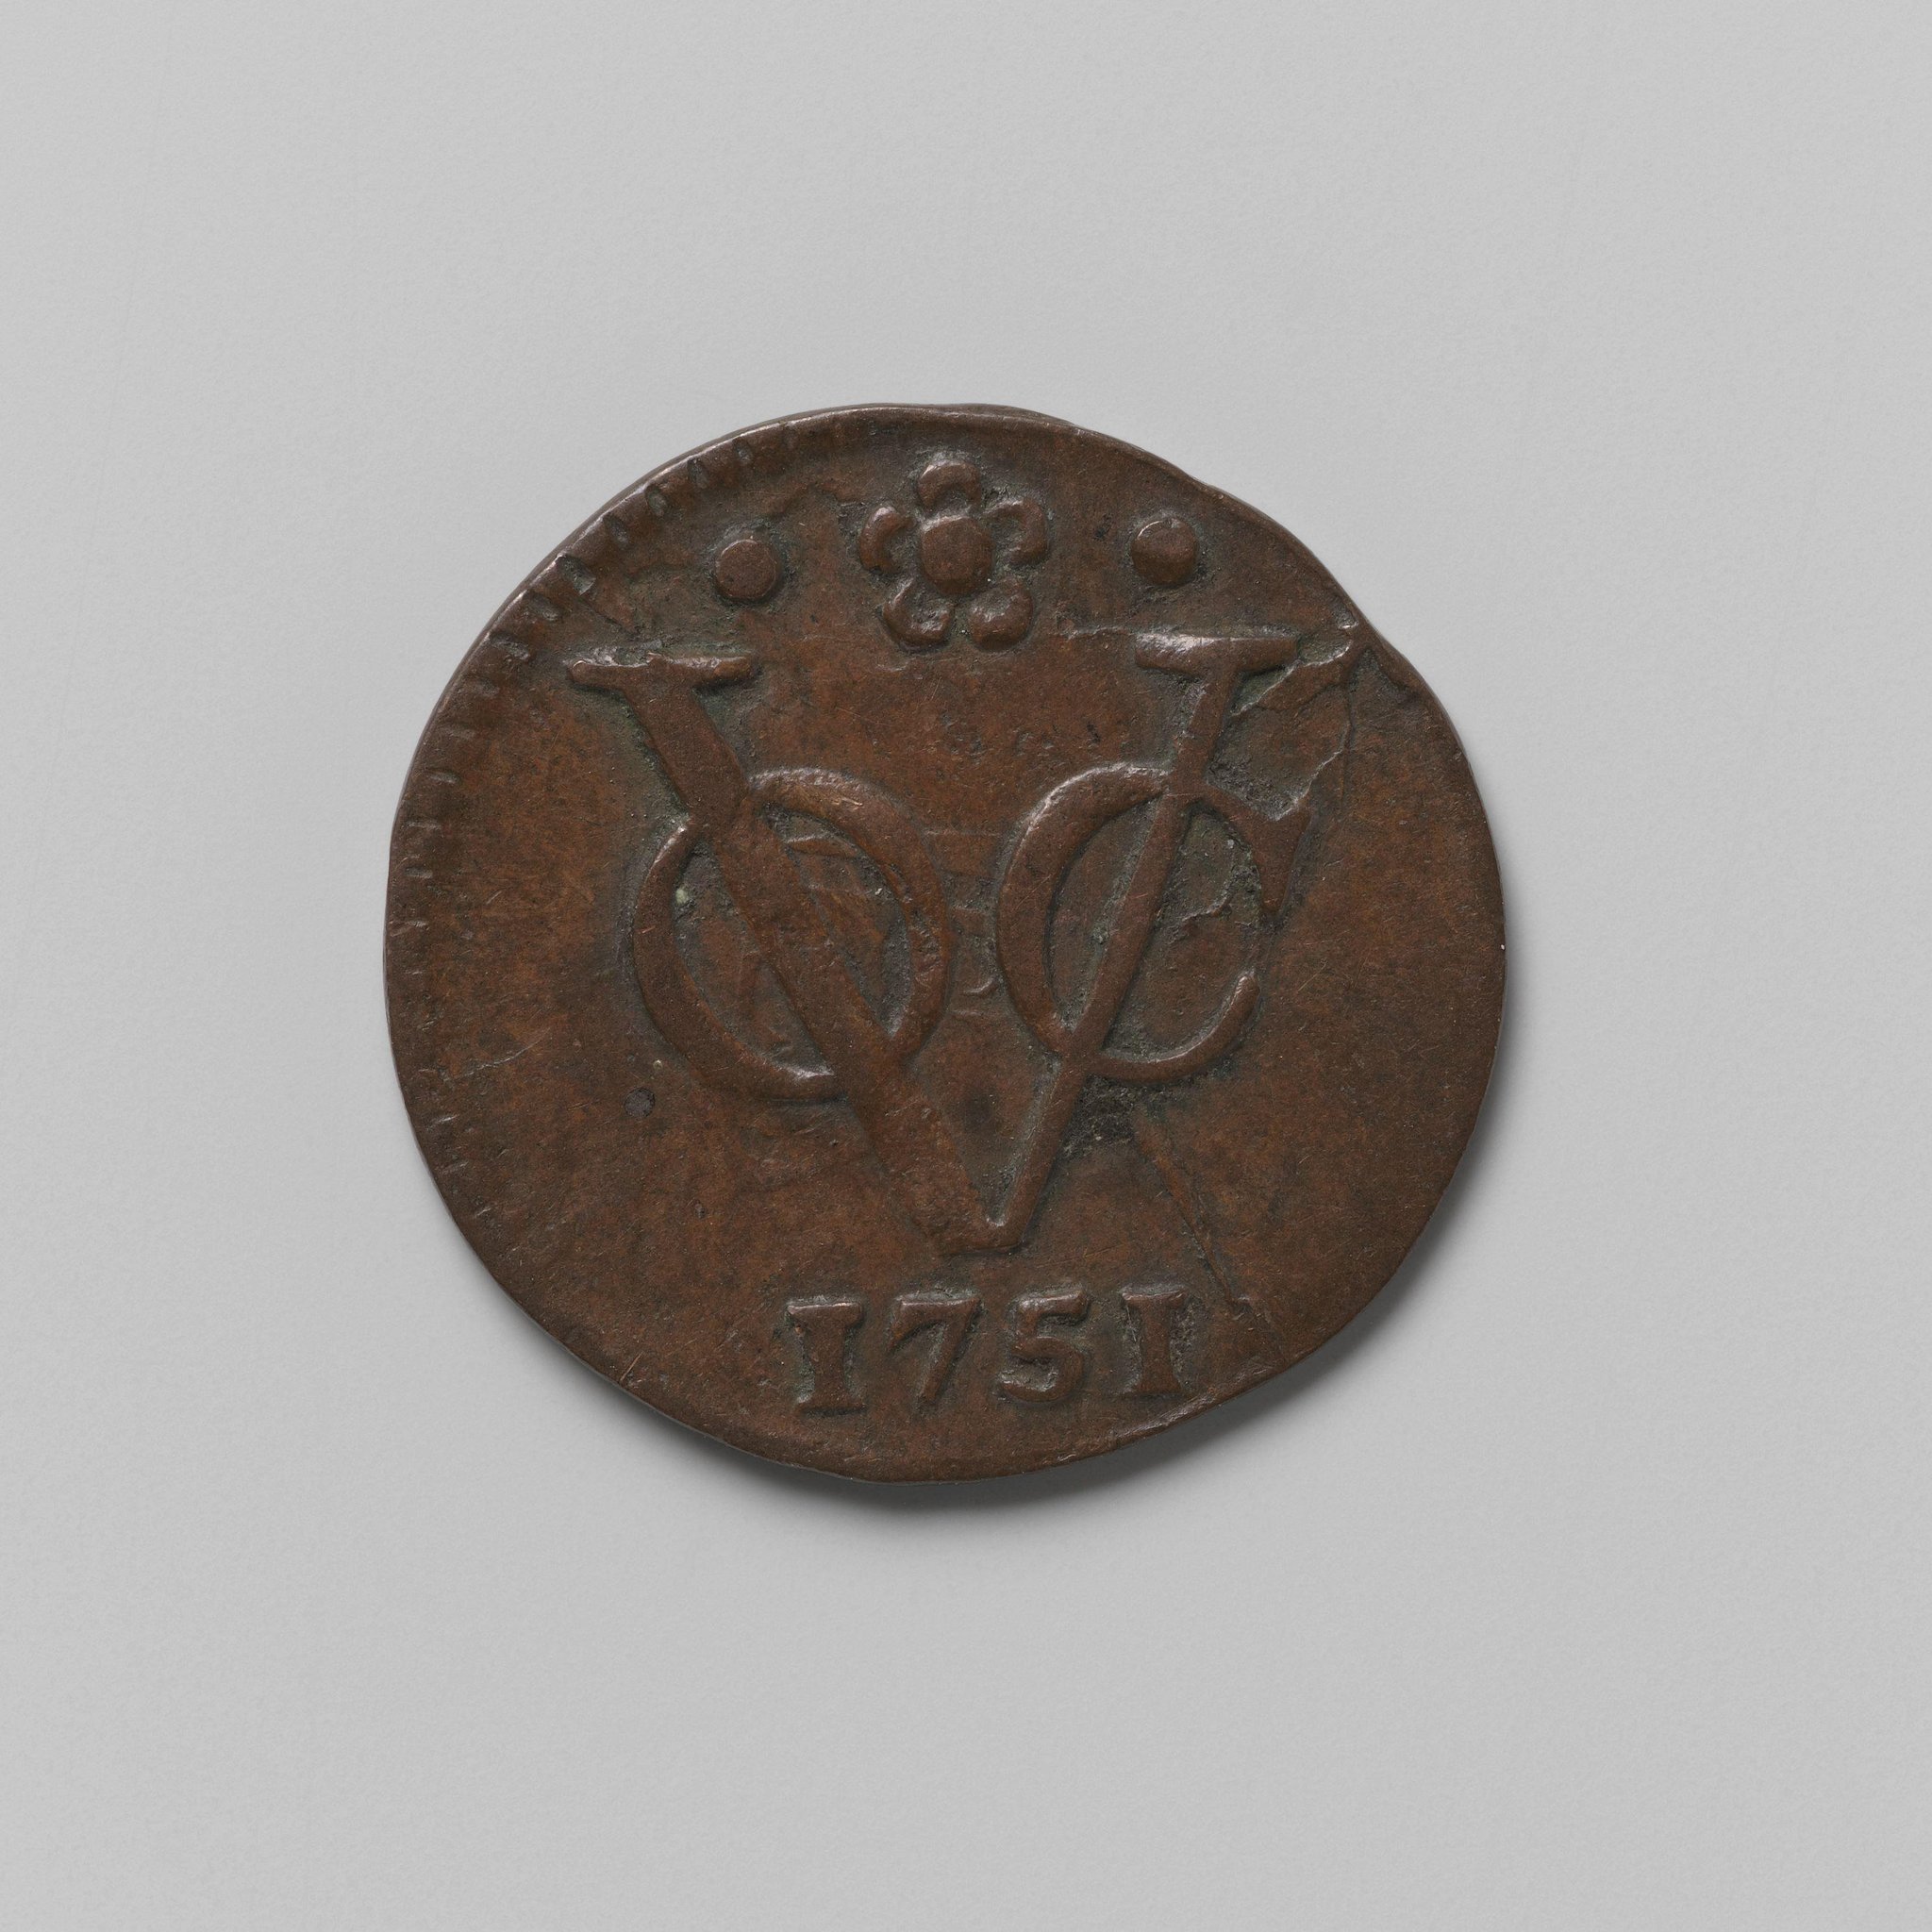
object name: coin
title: VOC, ½ duit Holland, 1751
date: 1751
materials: copper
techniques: striking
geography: dordrecht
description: Koperen munt. Voorzijde: gekroond wapenschild van Holland. Keerzijde: monogram van de VOC, waarboven muntteken en waaronder jaartal. Gladde rand.